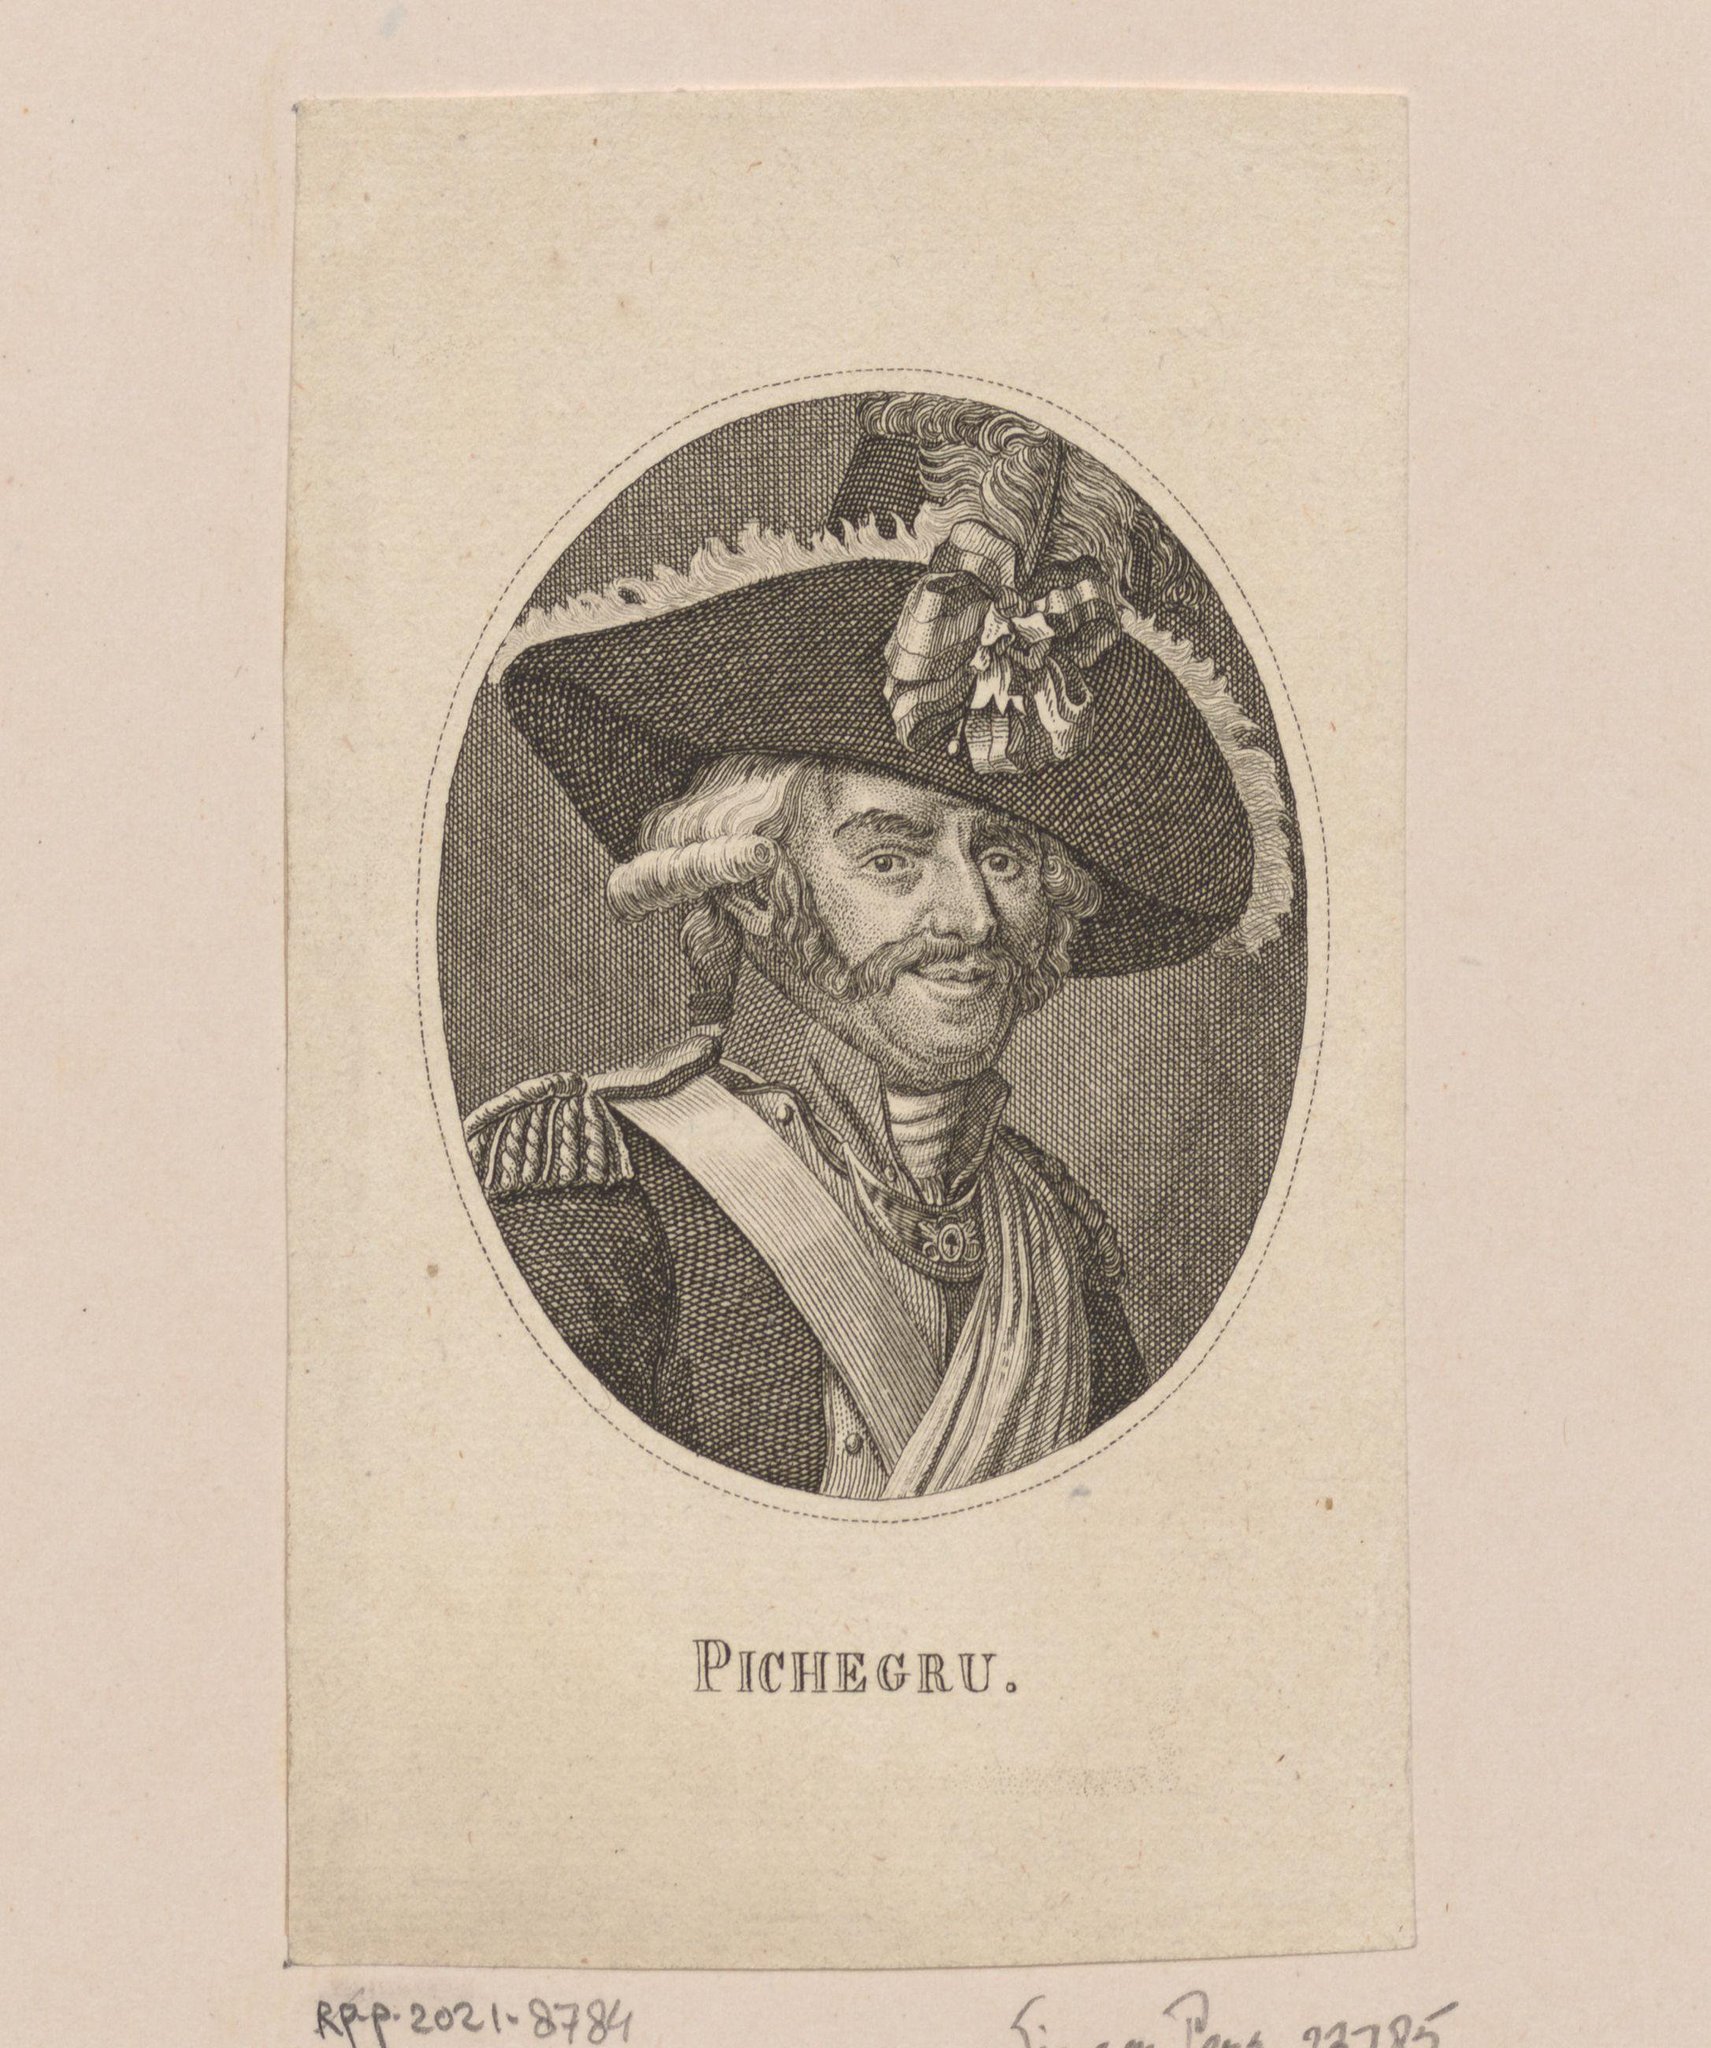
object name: print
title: Portret van Jean-Charles Pichegru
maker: Anonymous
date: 1783-1824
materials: paper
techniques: etching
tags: paris, politician, jean-charles pichegru, commander-in-chief, general, marshal, historical persons